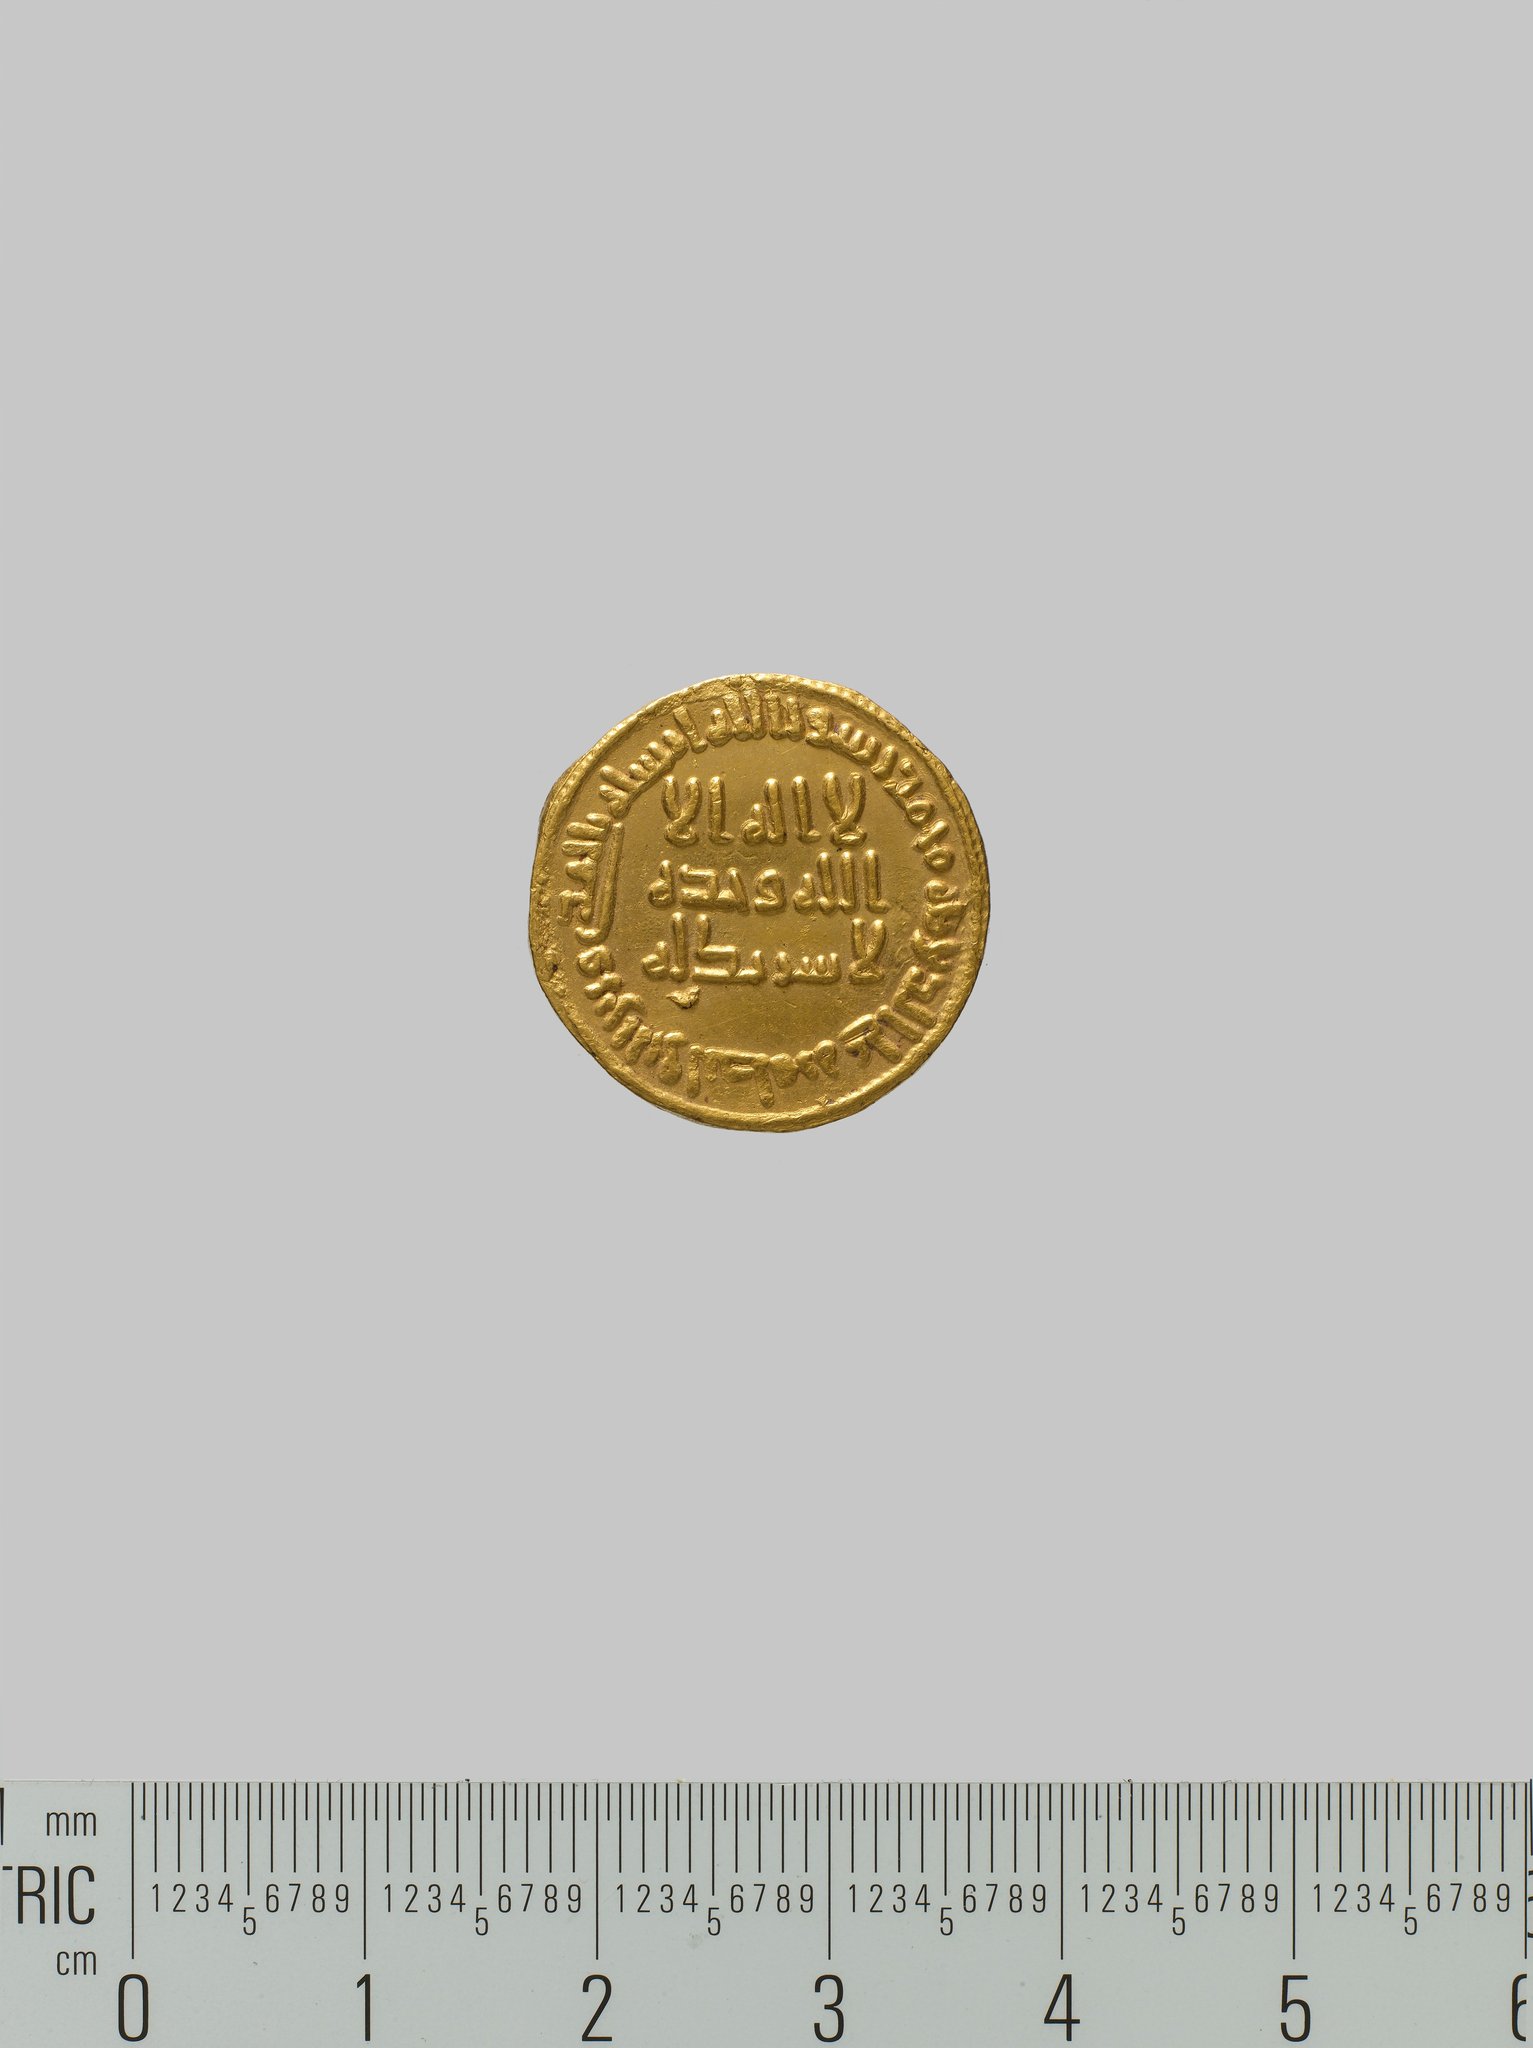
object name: coin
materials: gold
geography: iraq